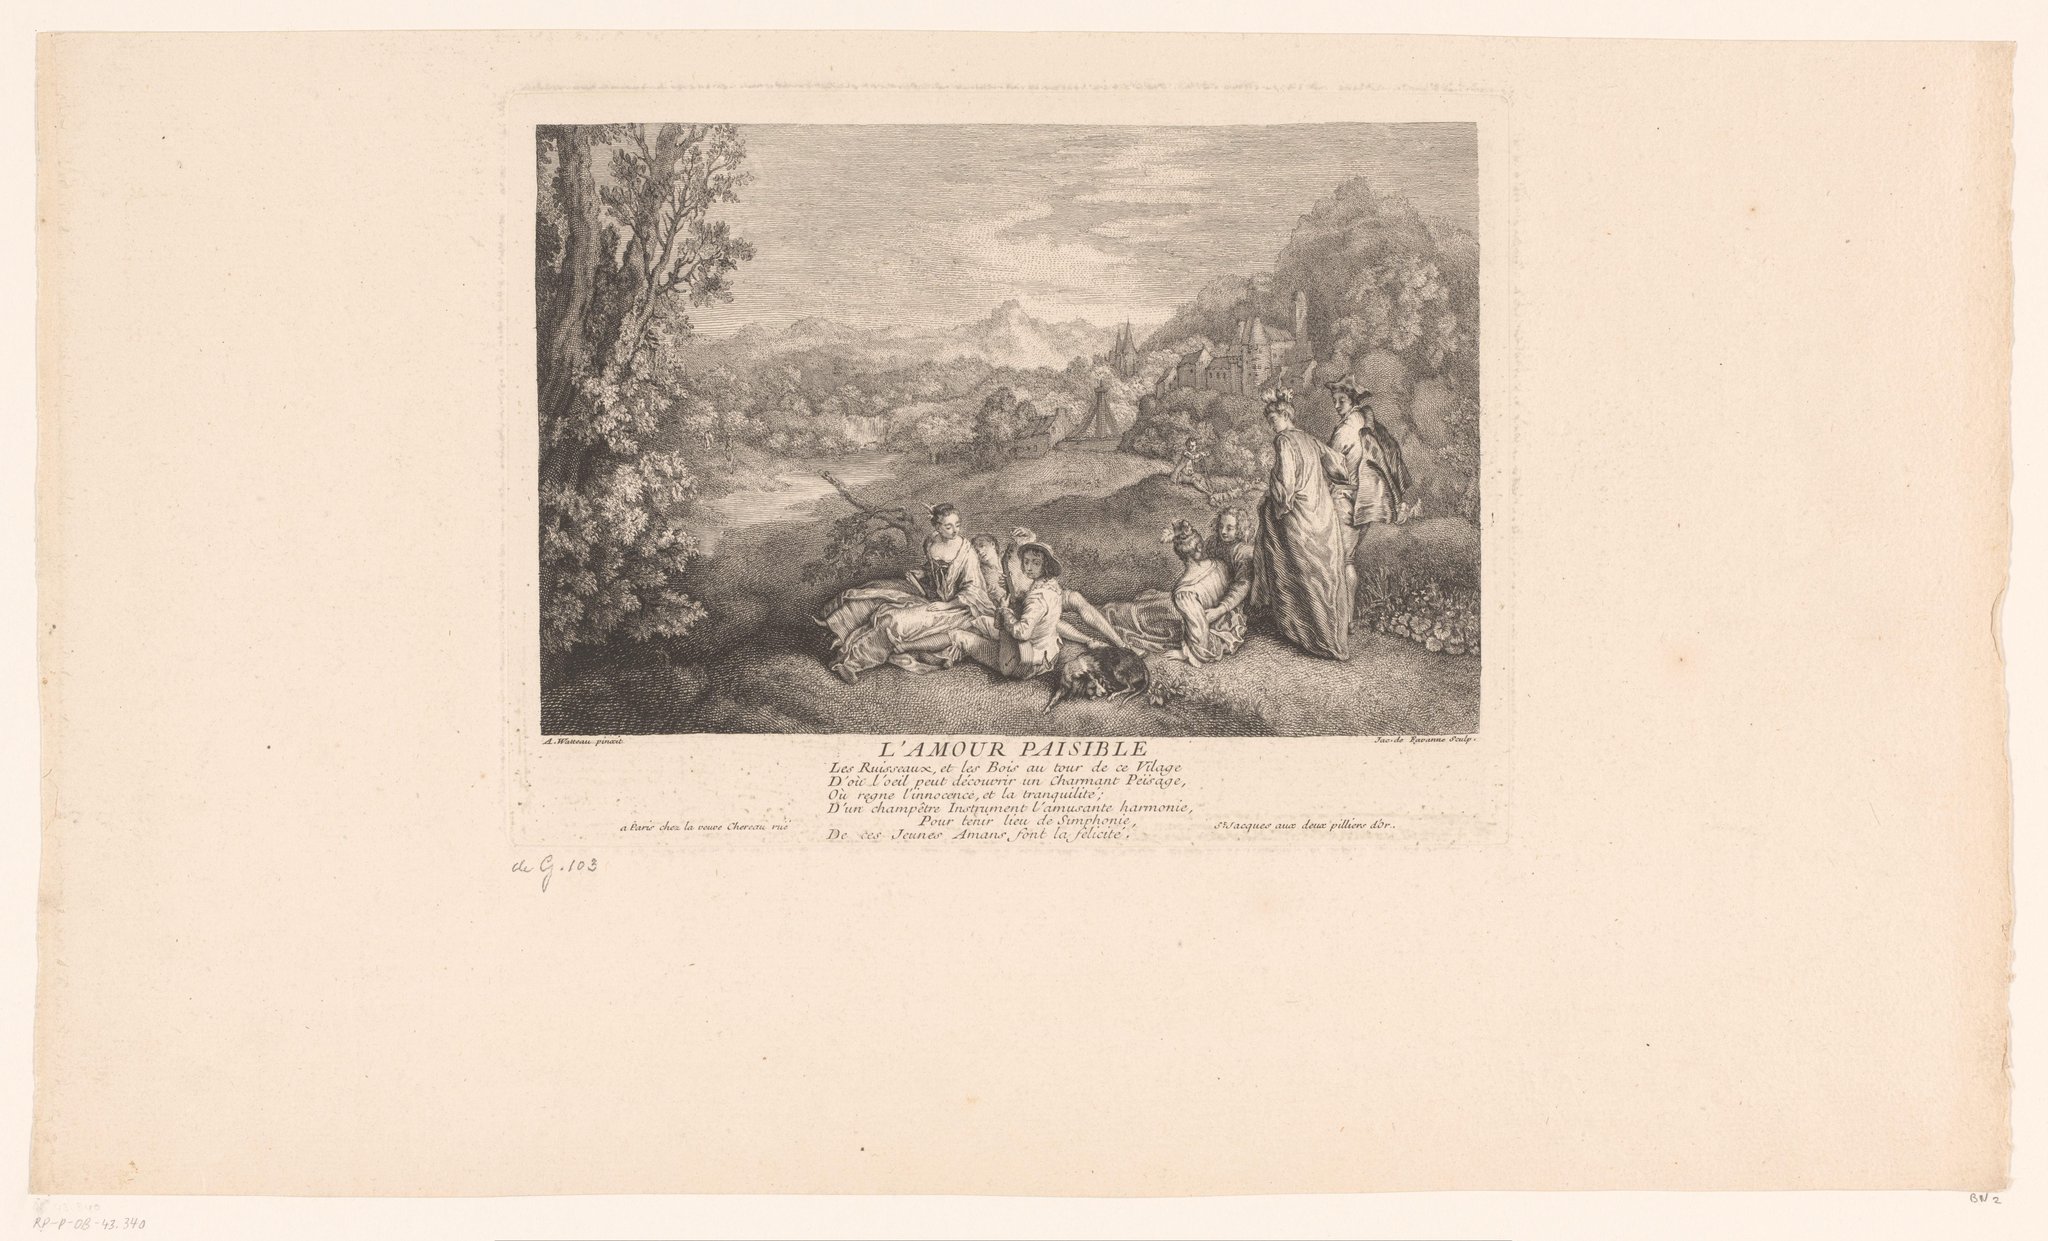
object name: print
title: Landschap met galant gezelschap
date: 1726-1770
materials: paper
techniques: engraving, etching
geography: paris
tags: garden of love, court of love, 'fête galante'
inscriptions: collector's mark: Lugt 2228